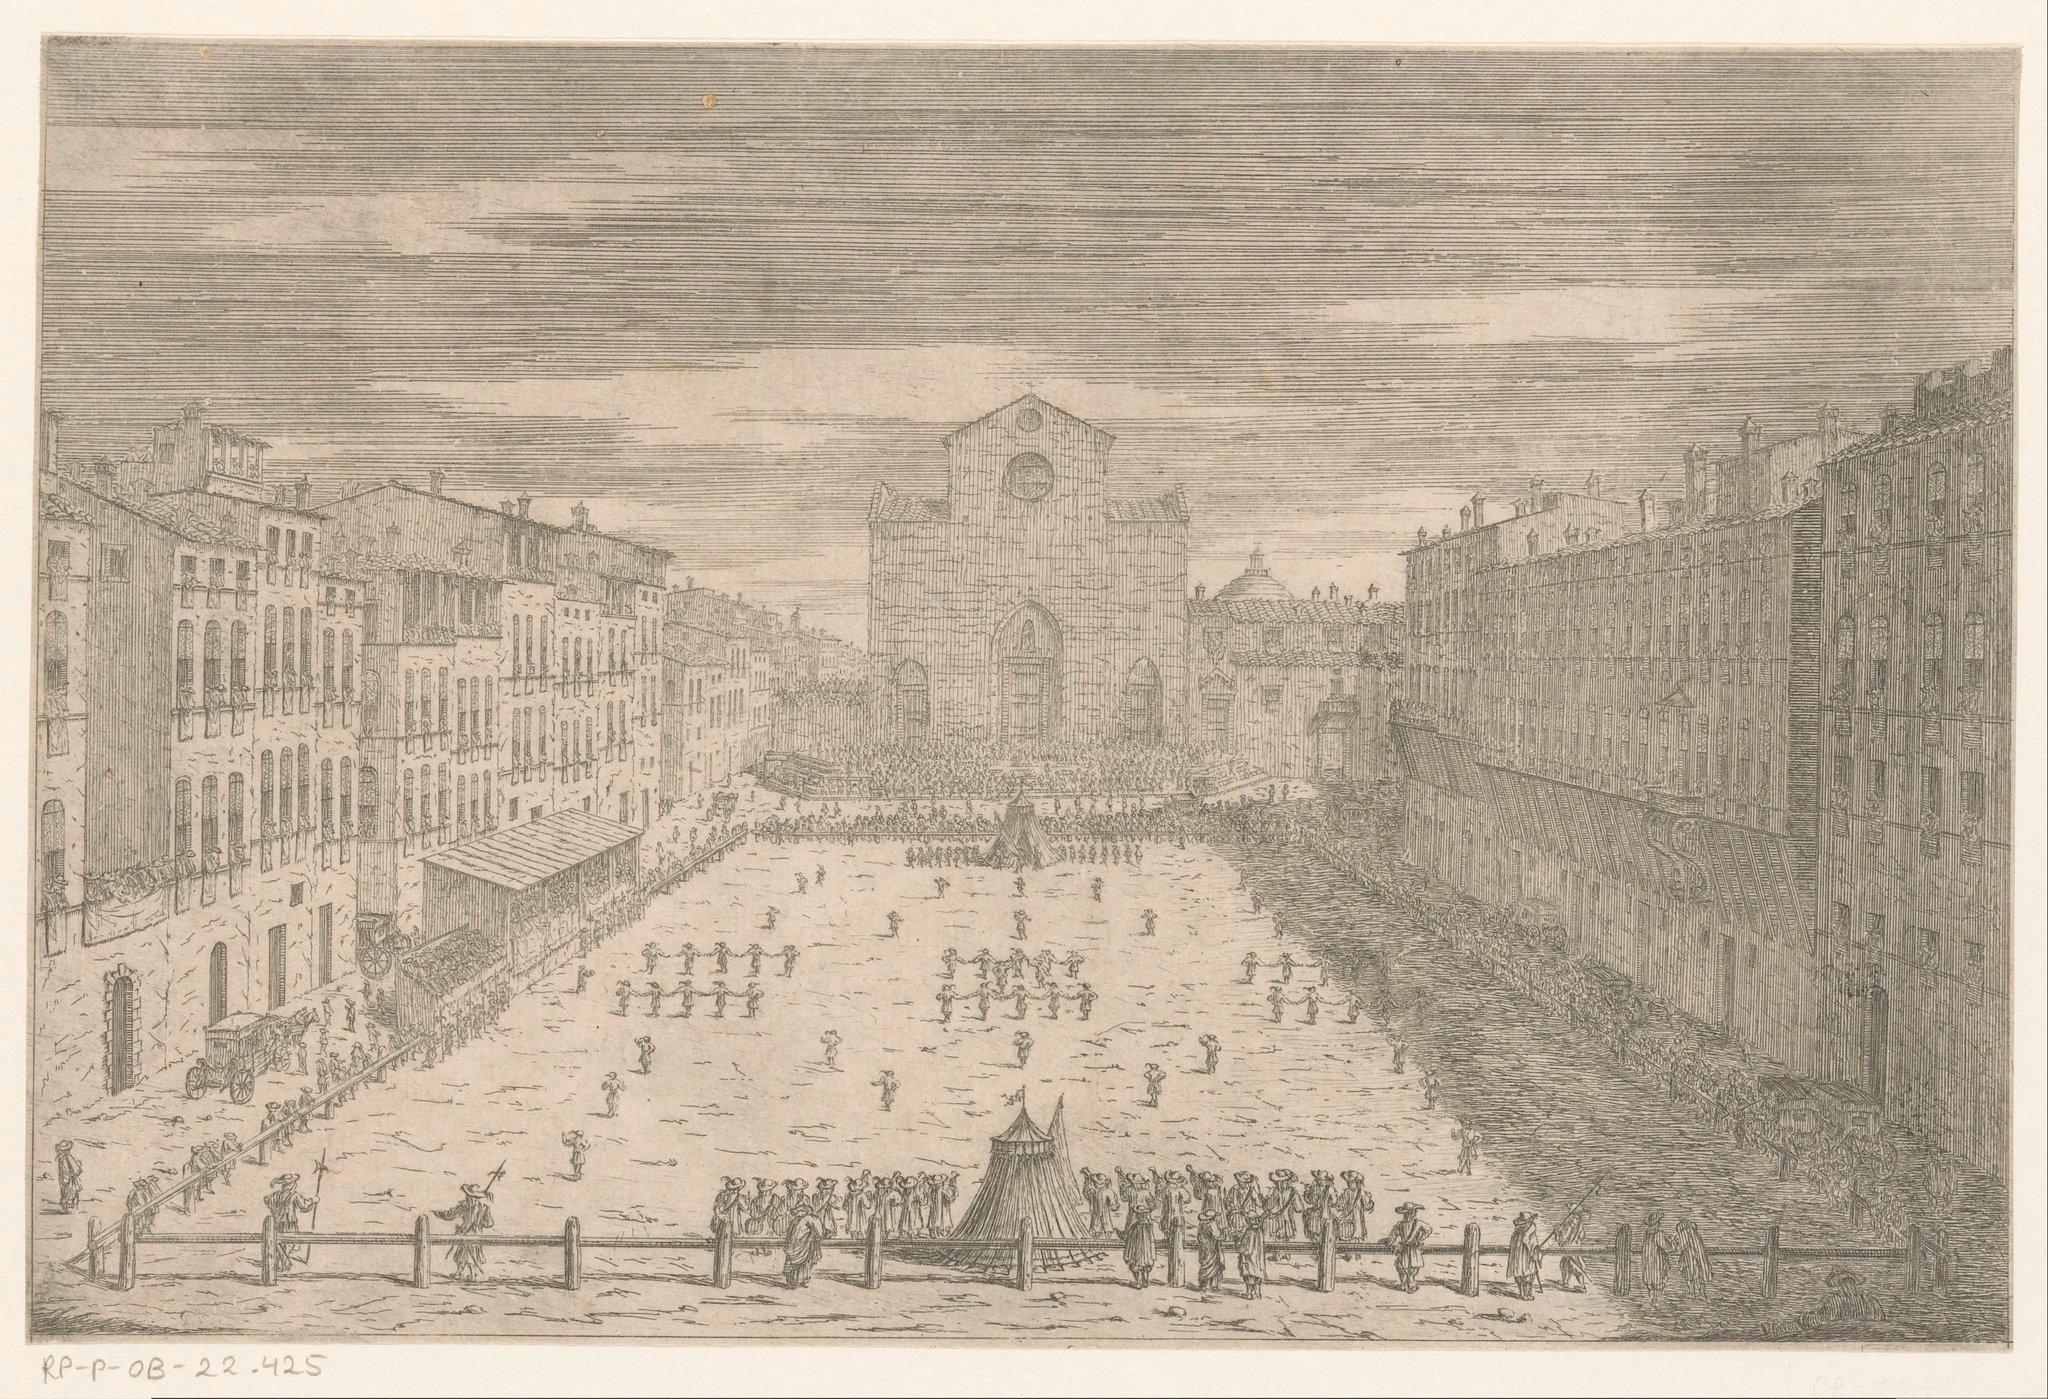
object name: print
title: Festiviteiten op Piazza Santa Croce voor de kerk de Santa Croce in Florence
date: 1616-1656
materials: paper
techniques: etching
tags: square, place, circus, etc., city-view, and landscape with man-made constructions, church (exterior), public festivities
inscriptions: collector's mark: Lugt 240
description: Gezicht op Piazza Santa Croce te Florence met op de achtergrond de kerk de Santa Croce. Op het plein vinden festiviteiten plaats.